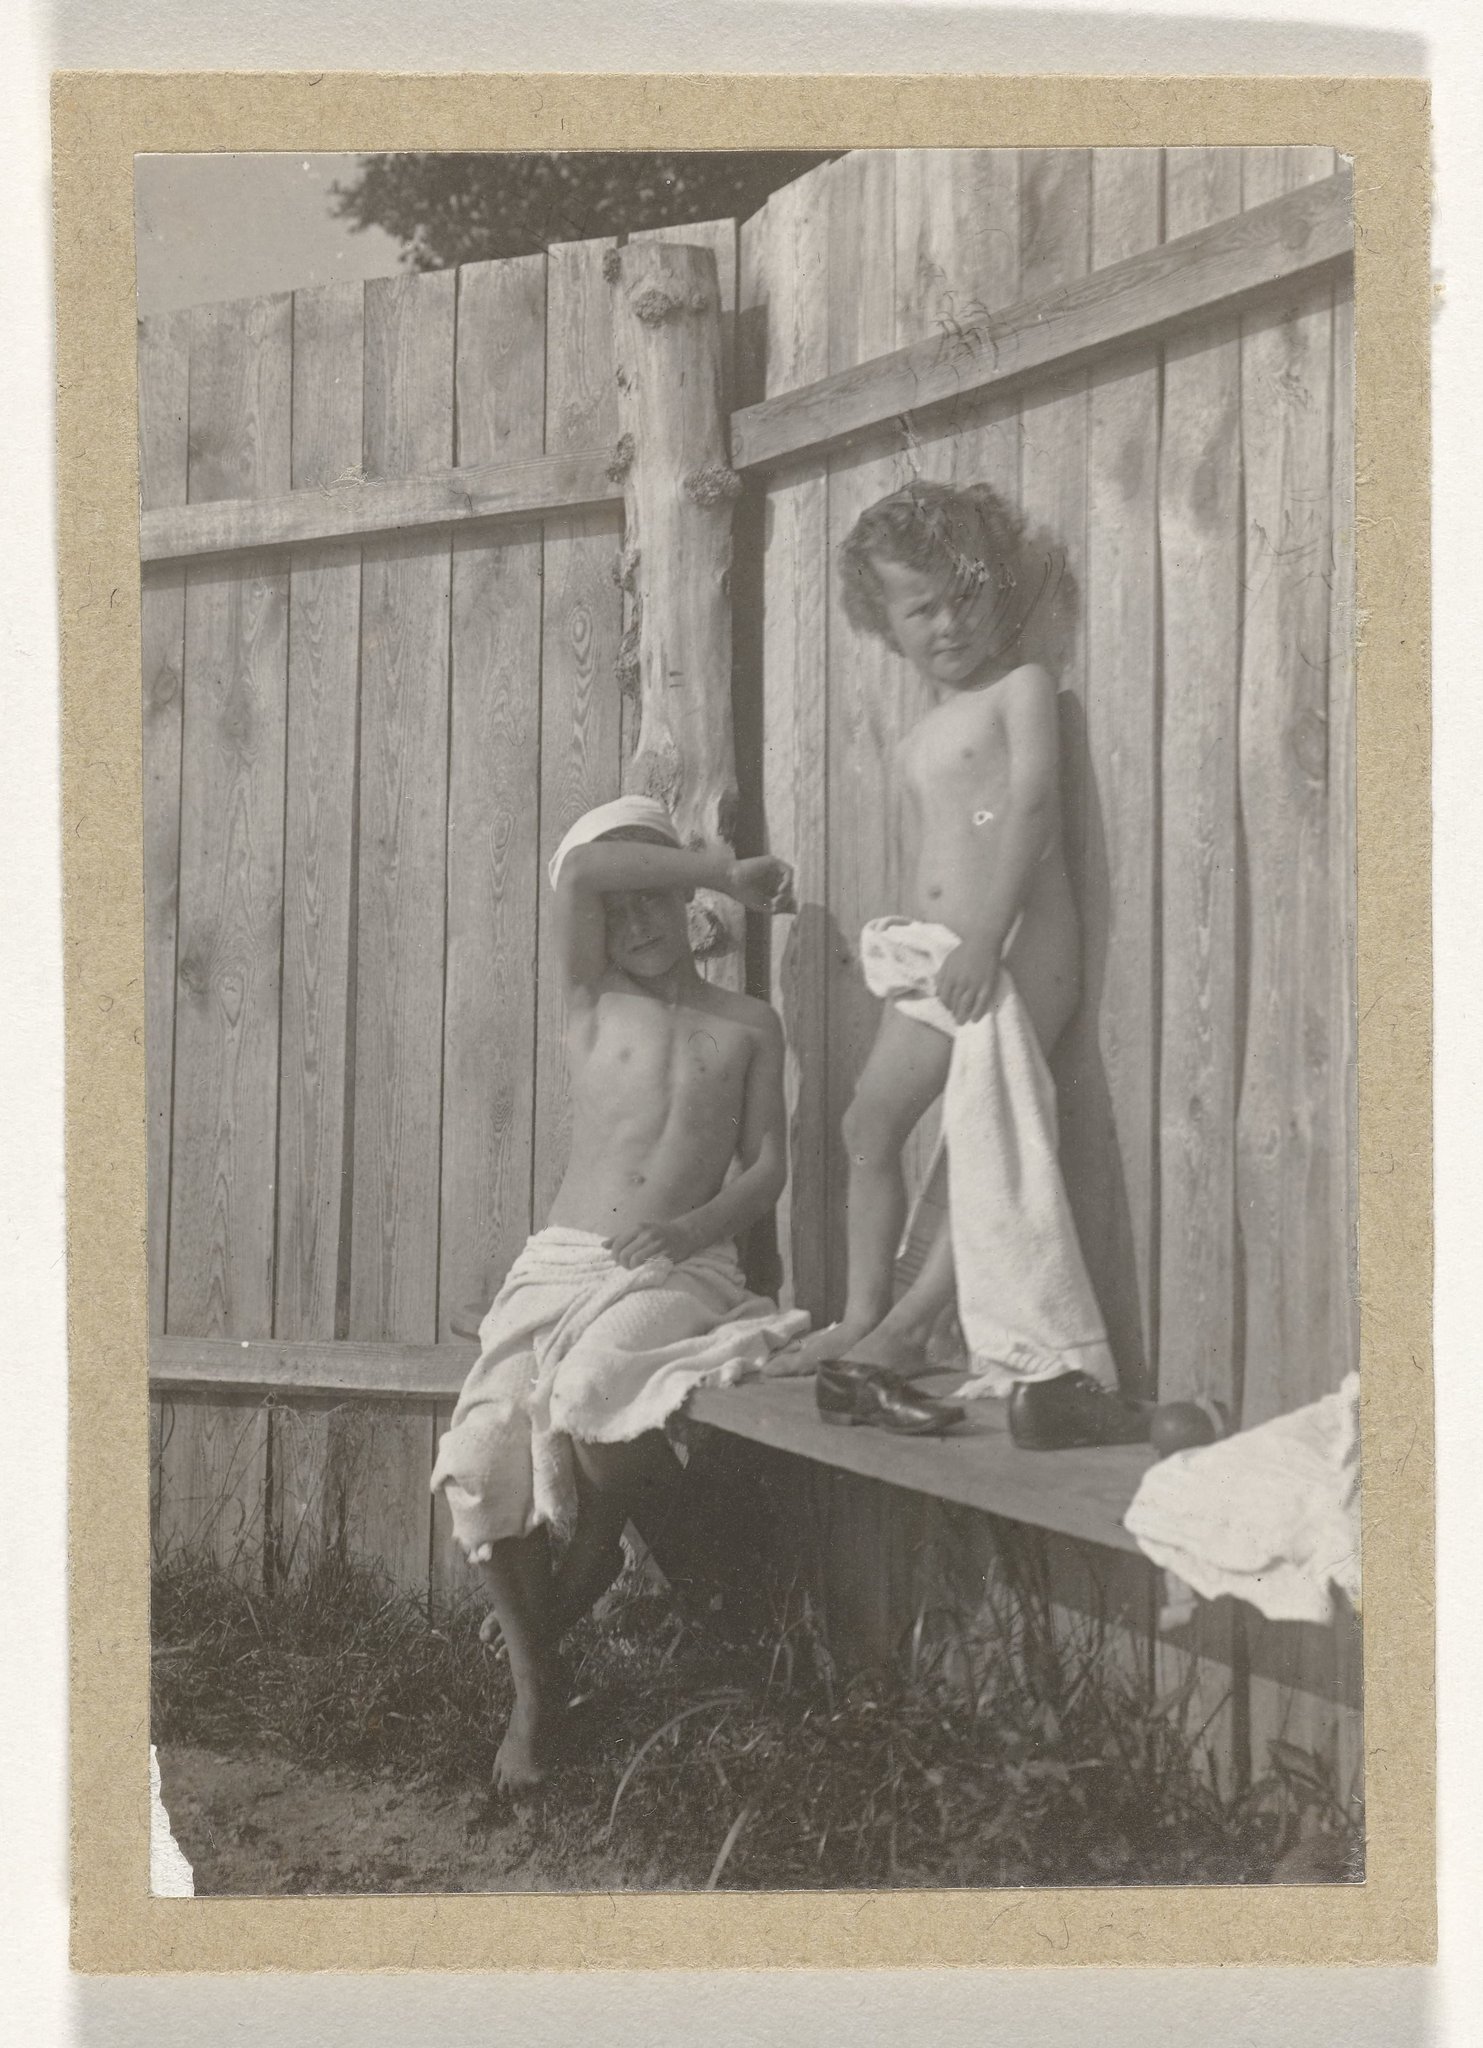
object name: photograph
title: Eckart Titzenthaler, zoon van de fotograaf, en een onbekende jongen staand voor een schutting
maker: waldemar titzenthaler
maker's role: fotograaf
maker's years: 1869-1937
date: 1918-1919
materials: paper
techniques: gelatin silver print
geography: germany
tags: engineer, boy (child between toddler and youth), germany